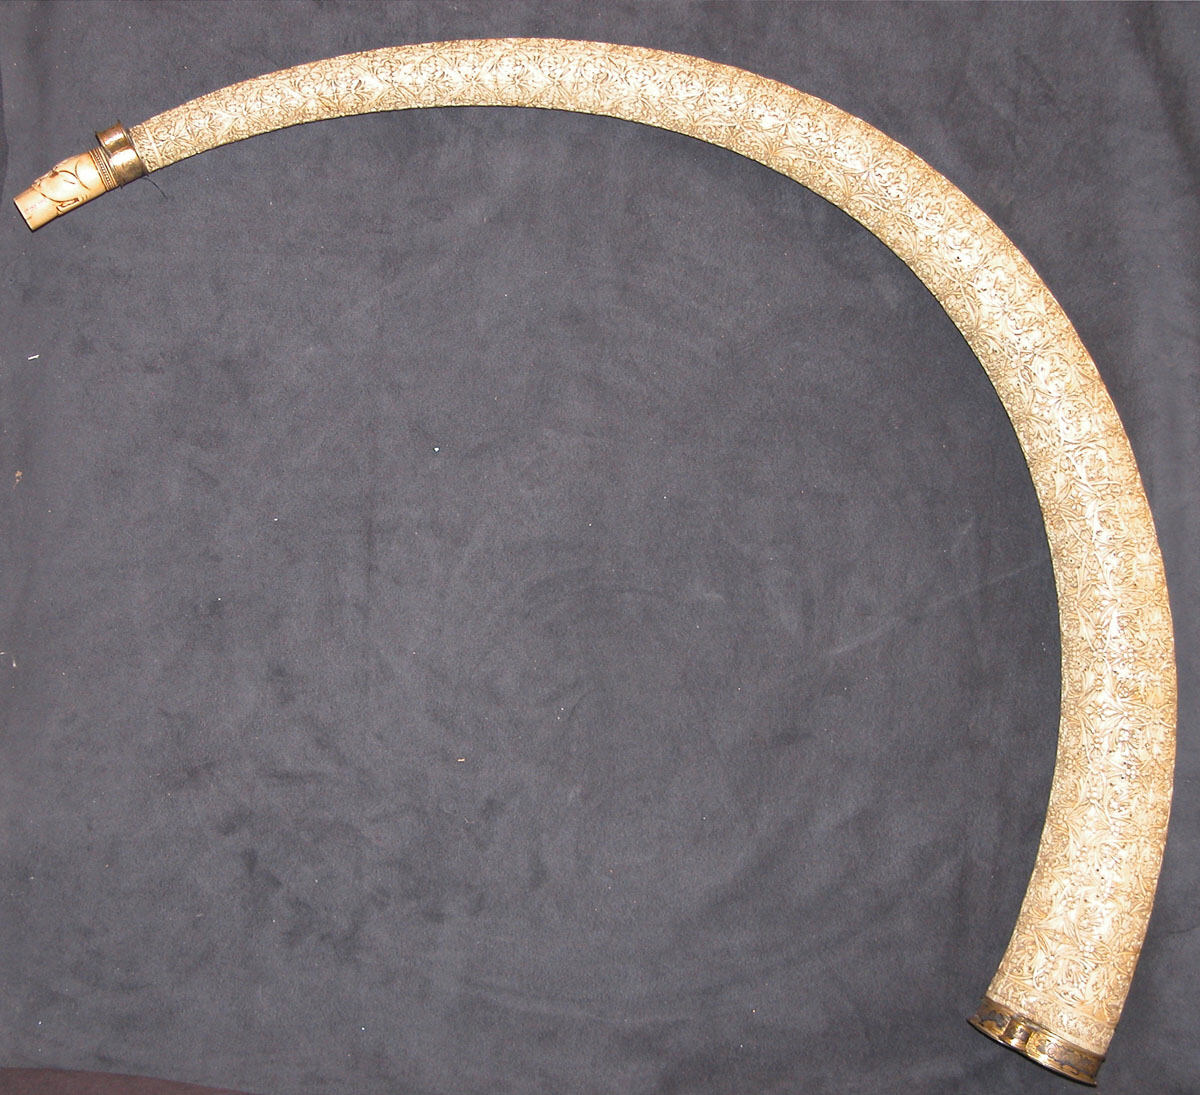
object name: hunting horn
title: Hunting Horn (Oliphant)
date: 1701-1800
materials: gilt silver, ivory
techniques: carving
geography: india